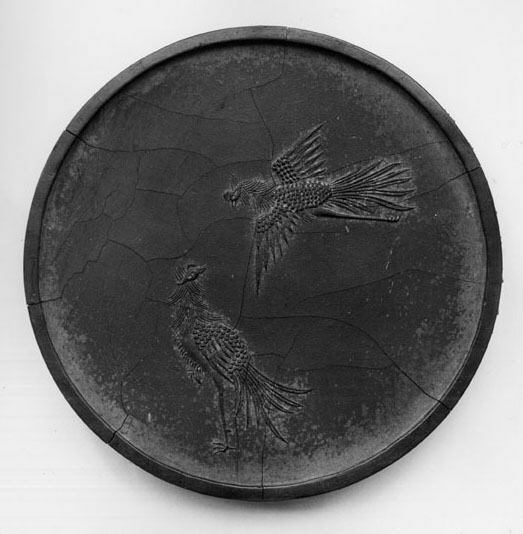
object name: ink tablet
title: Ink Tablet with Two Phoenixes Design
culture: chinese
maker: cheng junfang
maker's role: artist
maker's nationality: chinese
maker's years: 1541-1620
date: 1867-1933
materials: ink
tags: phoenix